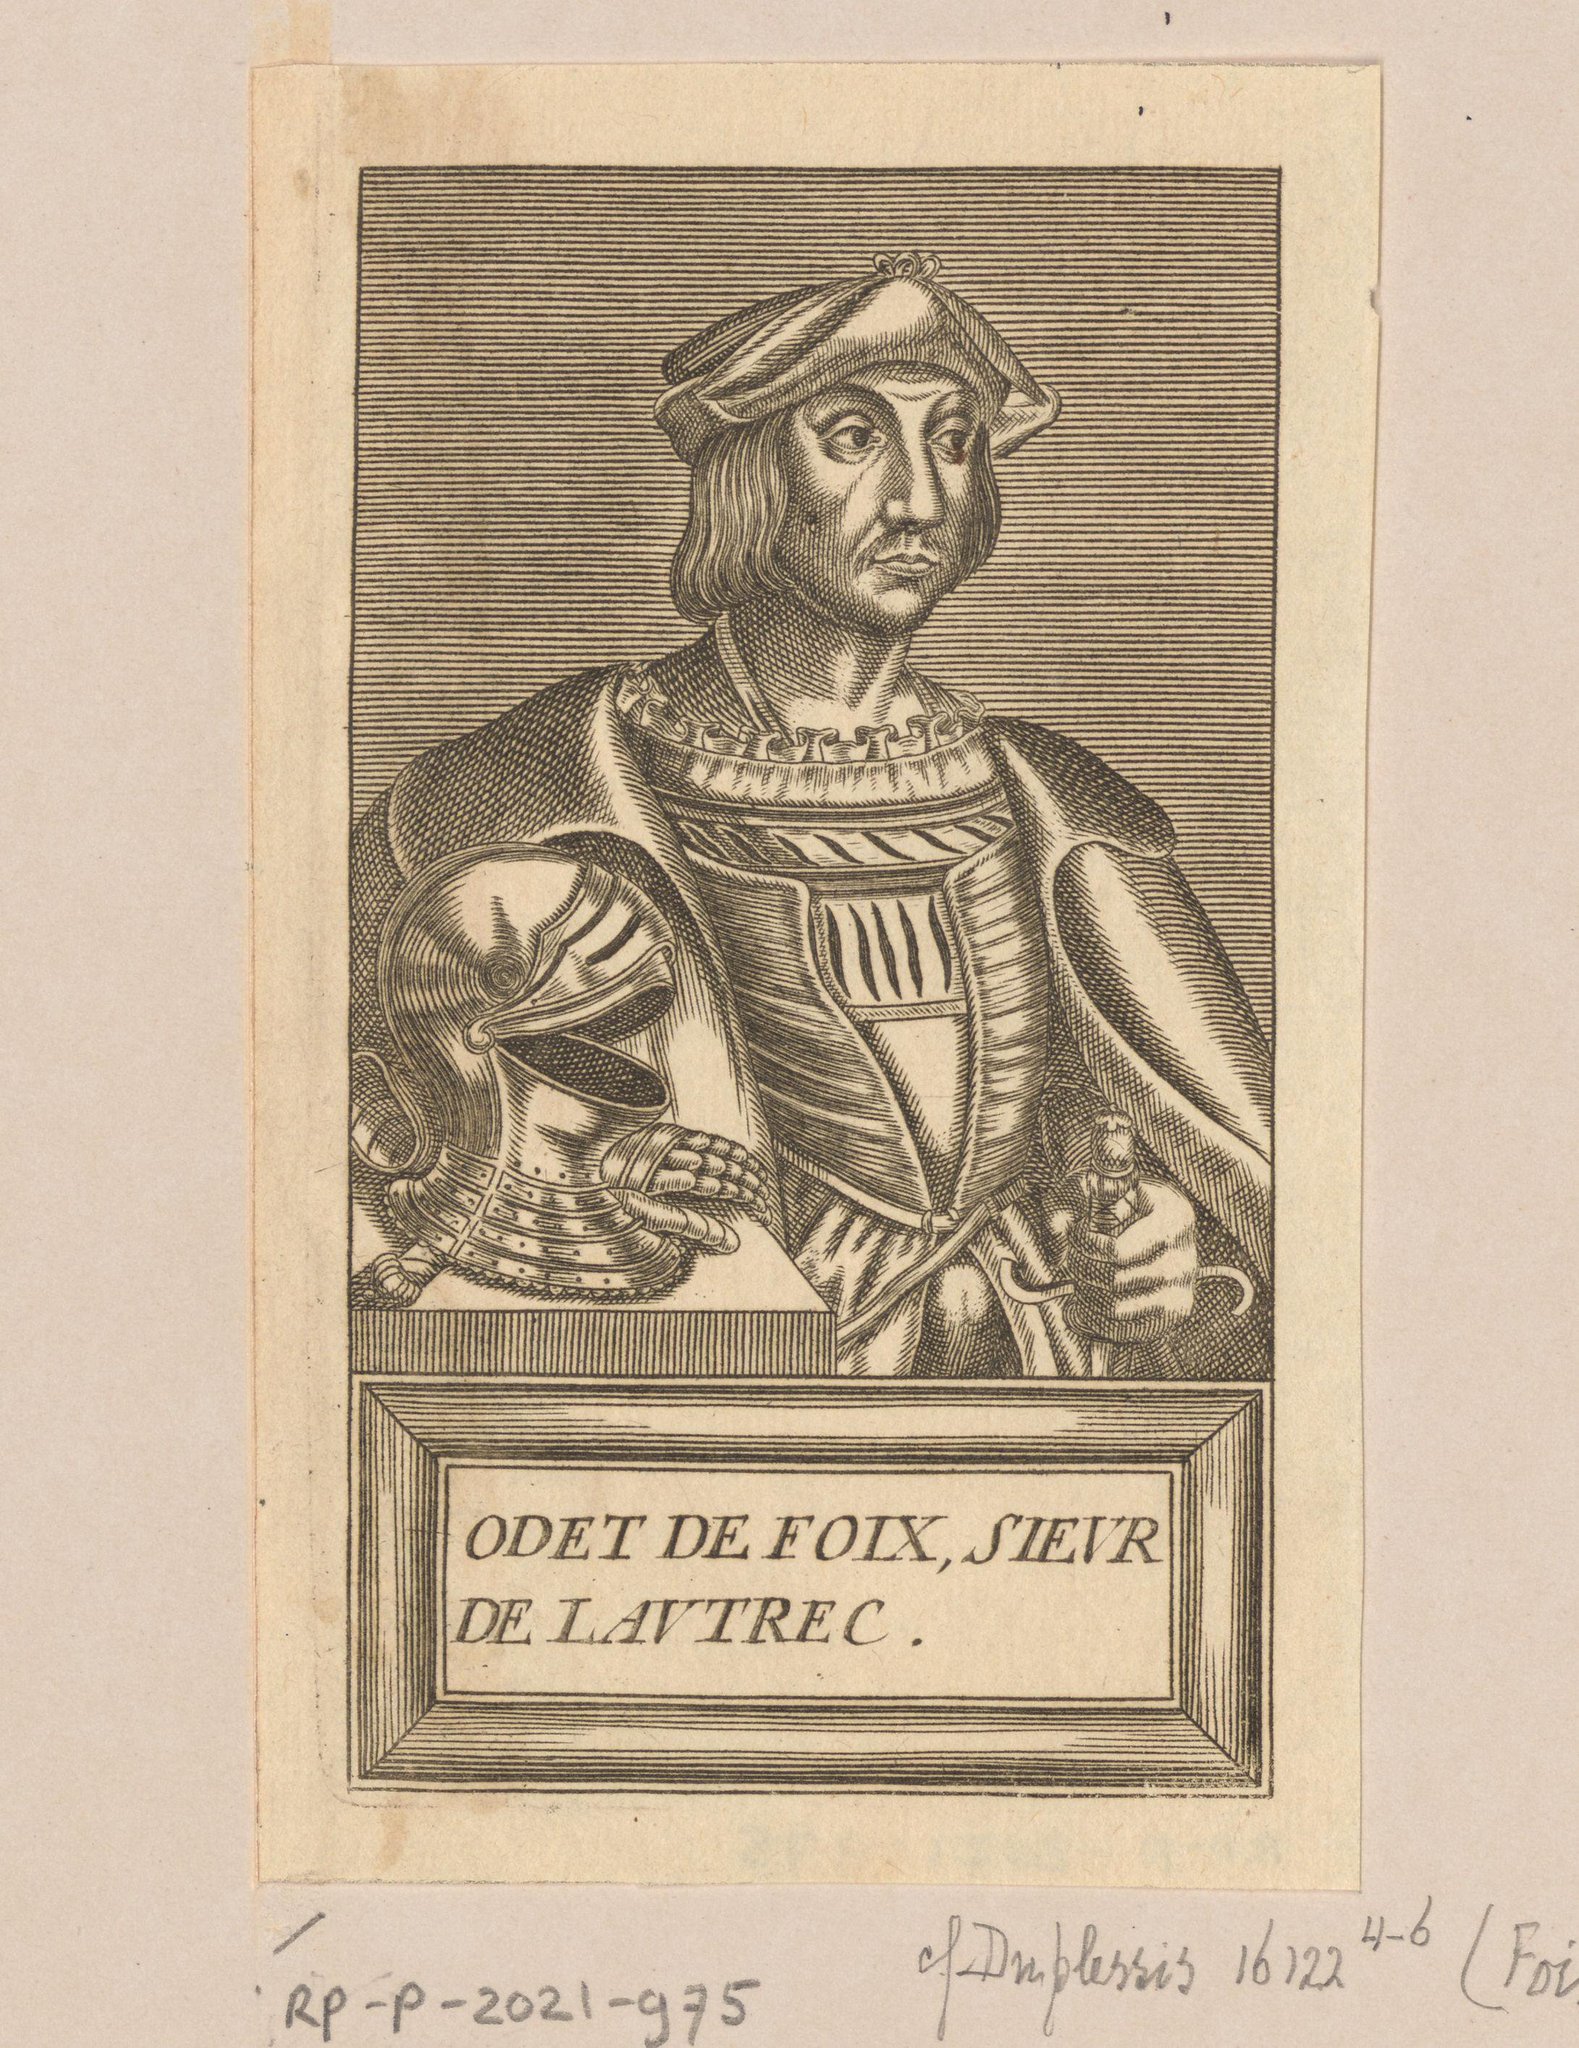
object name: print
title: Portret van Odet de Foix, burggraaf van Lautrec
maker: Anonymous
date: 1700-1799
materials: paper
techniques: engraving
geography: france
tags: helmet, historical persons